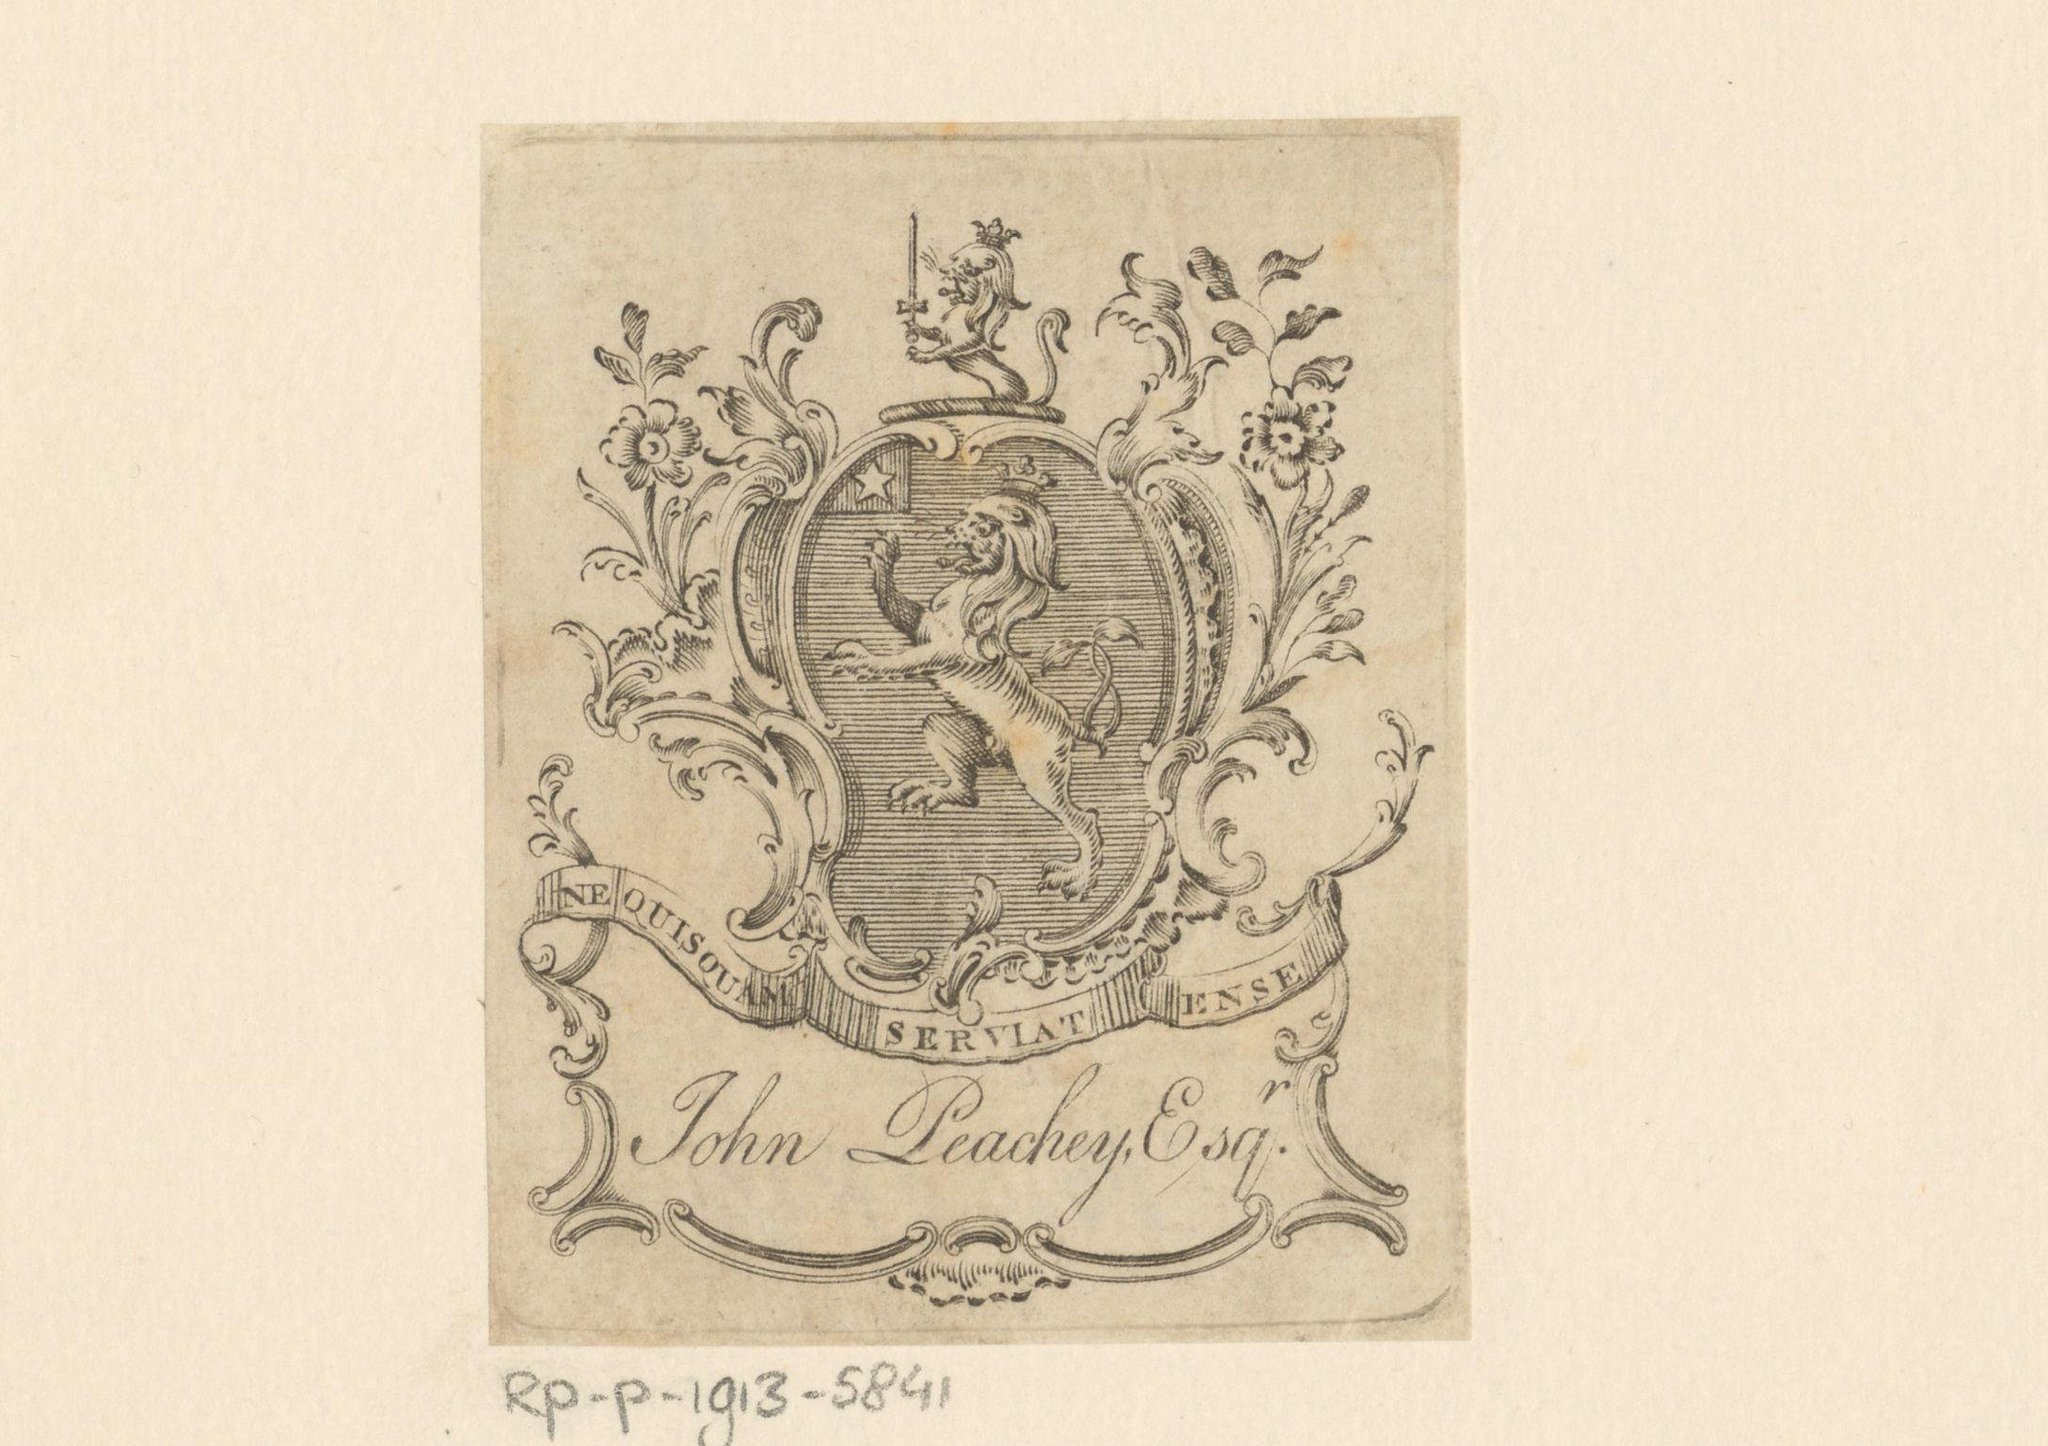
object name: bookplate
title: Ex libris van John Peachey Esqr.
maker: Anonymous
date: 1750-1782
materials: paper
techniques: engraving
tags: armorial bearing, heraldry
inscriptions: collector's mark: Lugt 2760, collector's mark: Lugt 2233